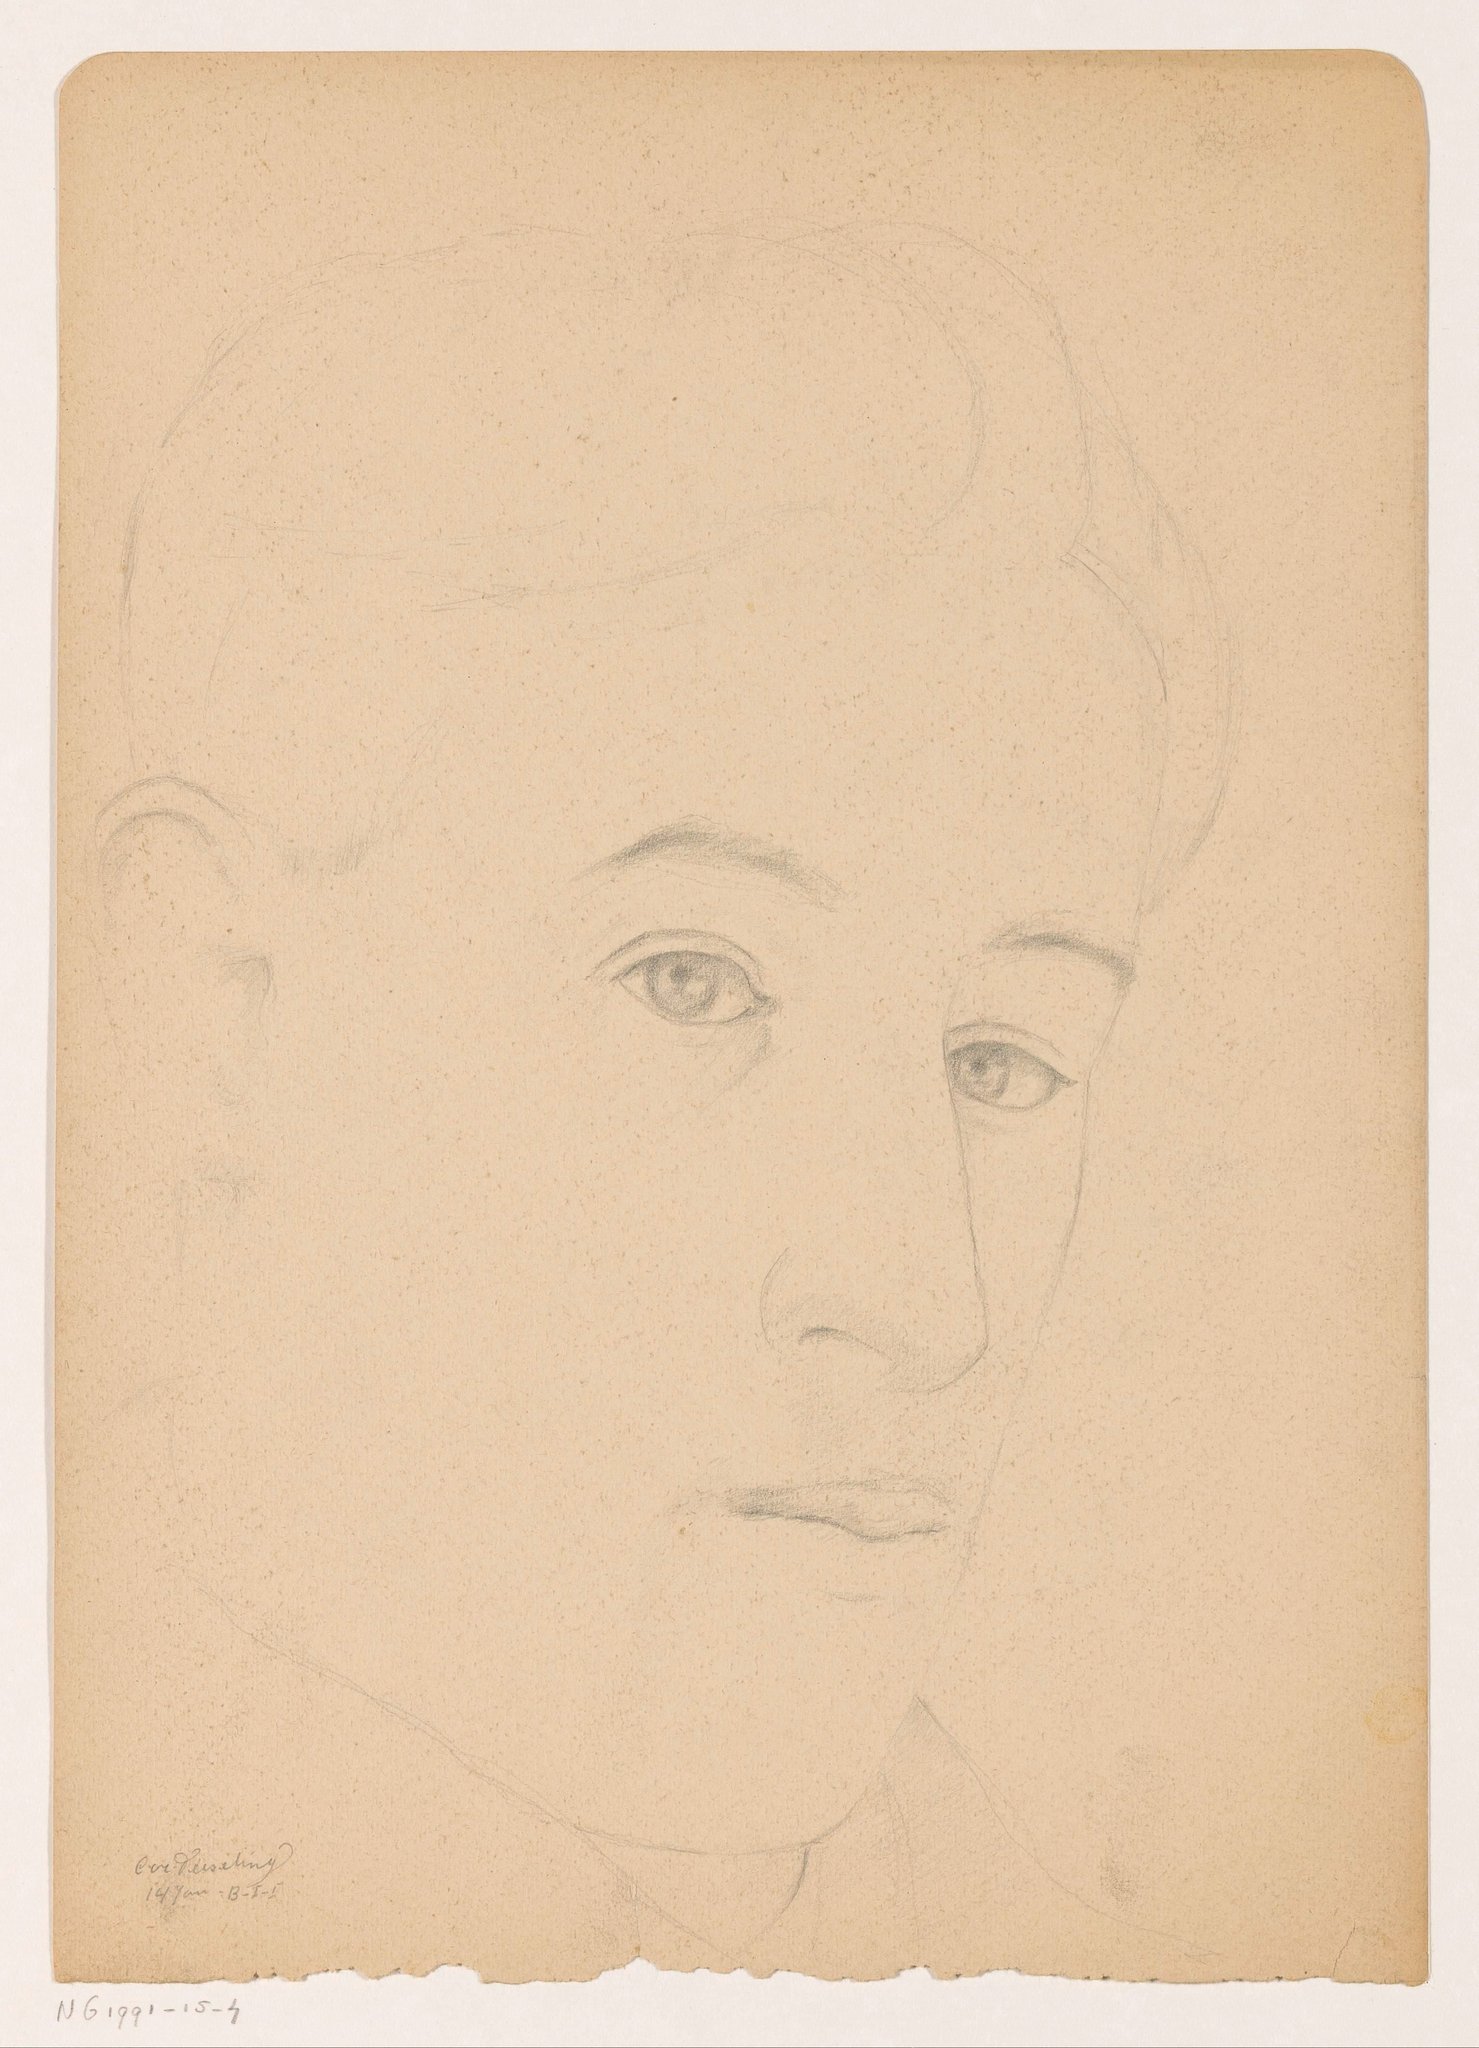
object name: drawing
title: Zelfportretten van Cor van Teeseling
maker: cor van teeseling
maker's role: draughtsman, sculptor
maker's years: 1915-1942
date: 1942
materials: paper, pencil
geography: weteringschans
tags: amsterdam, draughtsman, sculptor, cor van teeseling, historical persons, prisoner in cell or locked place, portrait, self-portrait of draughtsman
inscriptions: signature and date: ‘Cor van Teeseling / 14 Jan. / B-1-1’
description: Zelfportret van Cor van Teeseling: in de gevangenis aan de Weteringschans, cel B-1-1, 14 januari. Getekend zelfportret van Cor van Teeseling met zijn hoofd naar rechts gewend.